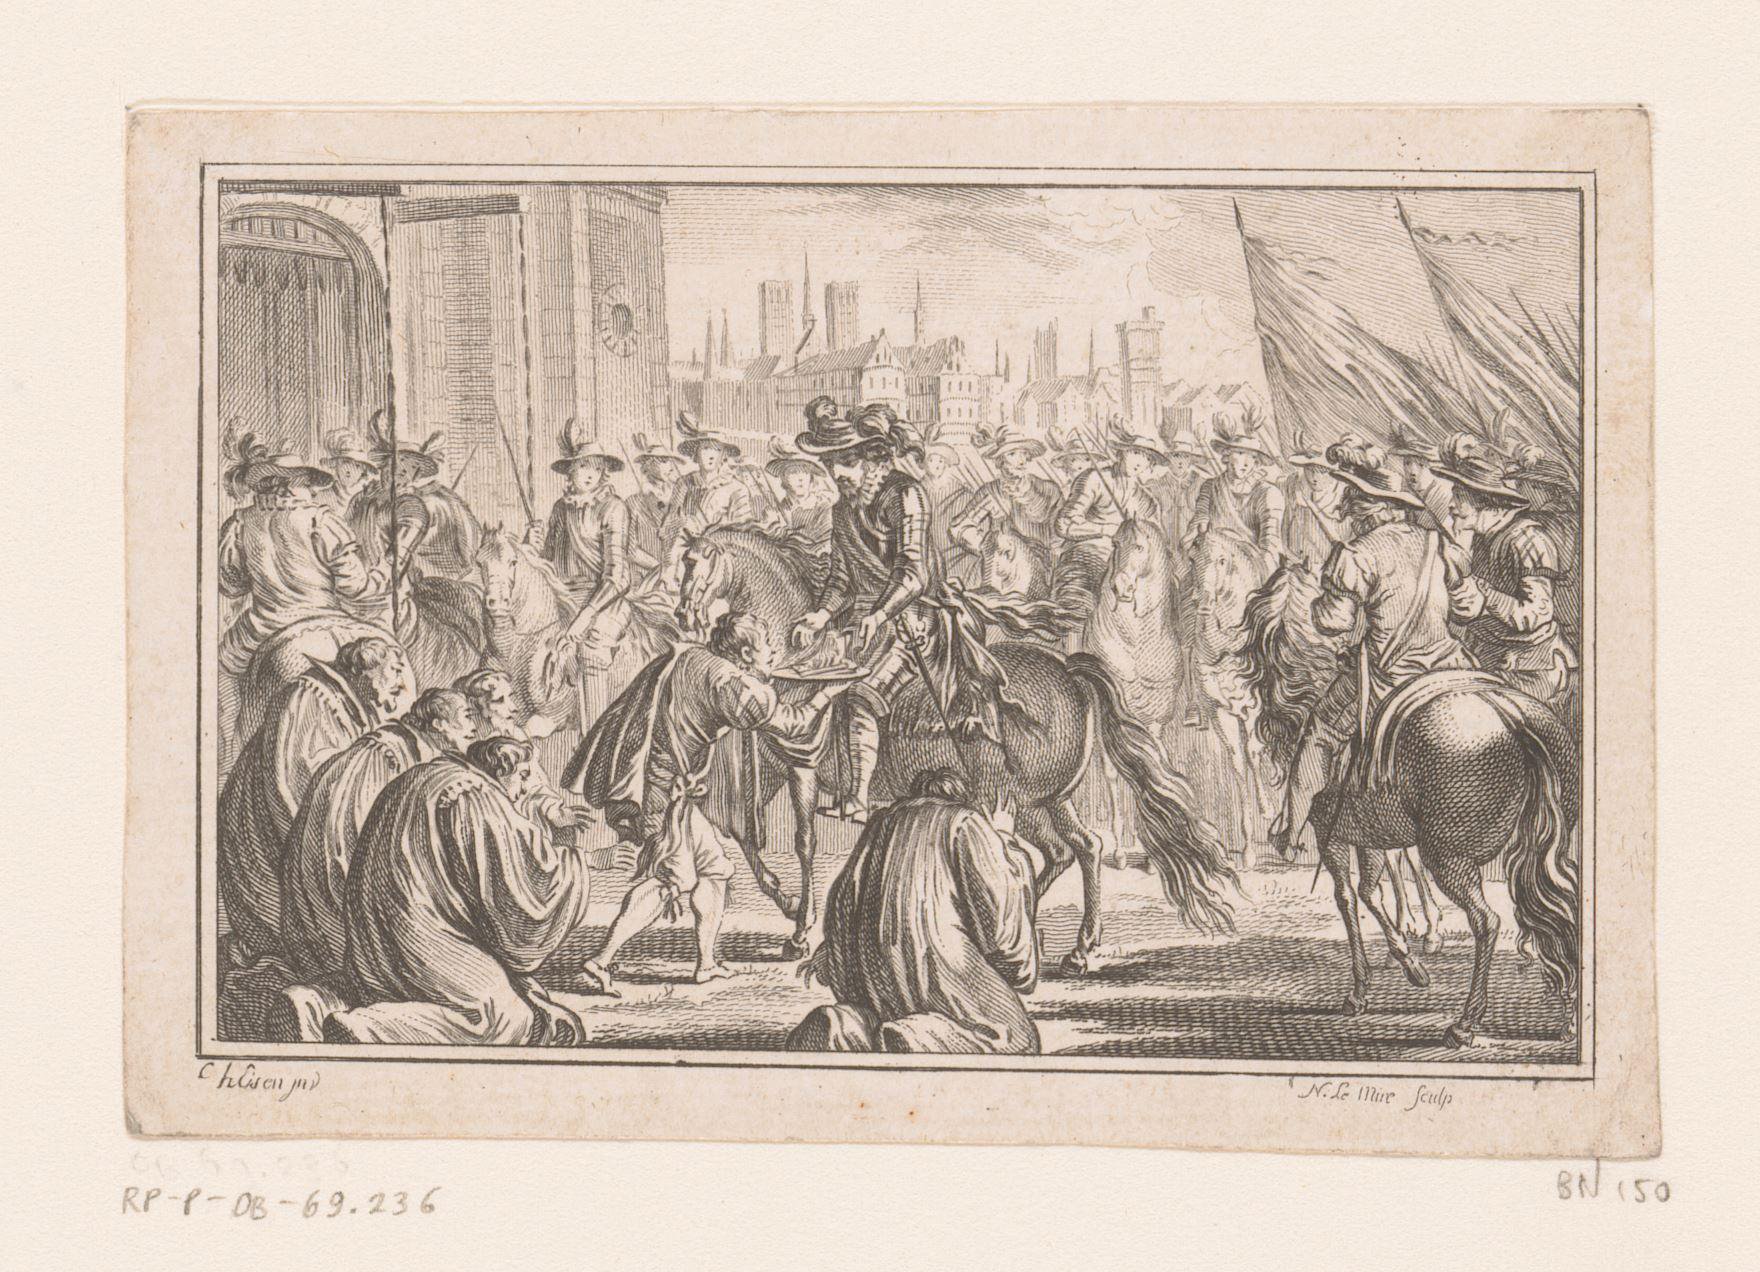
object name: print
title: Hendrik IV van Frankrijk te paard die de onderwerping van de Parijzenaars aanvaardt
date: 1757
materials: paper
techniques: engraving, etching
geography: france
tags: paris, hendrik iv (koning van frankrijk en navarra), ruler and his subjects, riding a horse, ass, or mule; rider, horseman, historical persons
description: Prent uit: Davila, Enrico Caterino. Histoire des guerres civiles de France sous les règnes de François II, Charles IX, Henri III et Henri IV. Amsterdam: Akrstée en Marcus, 1757.